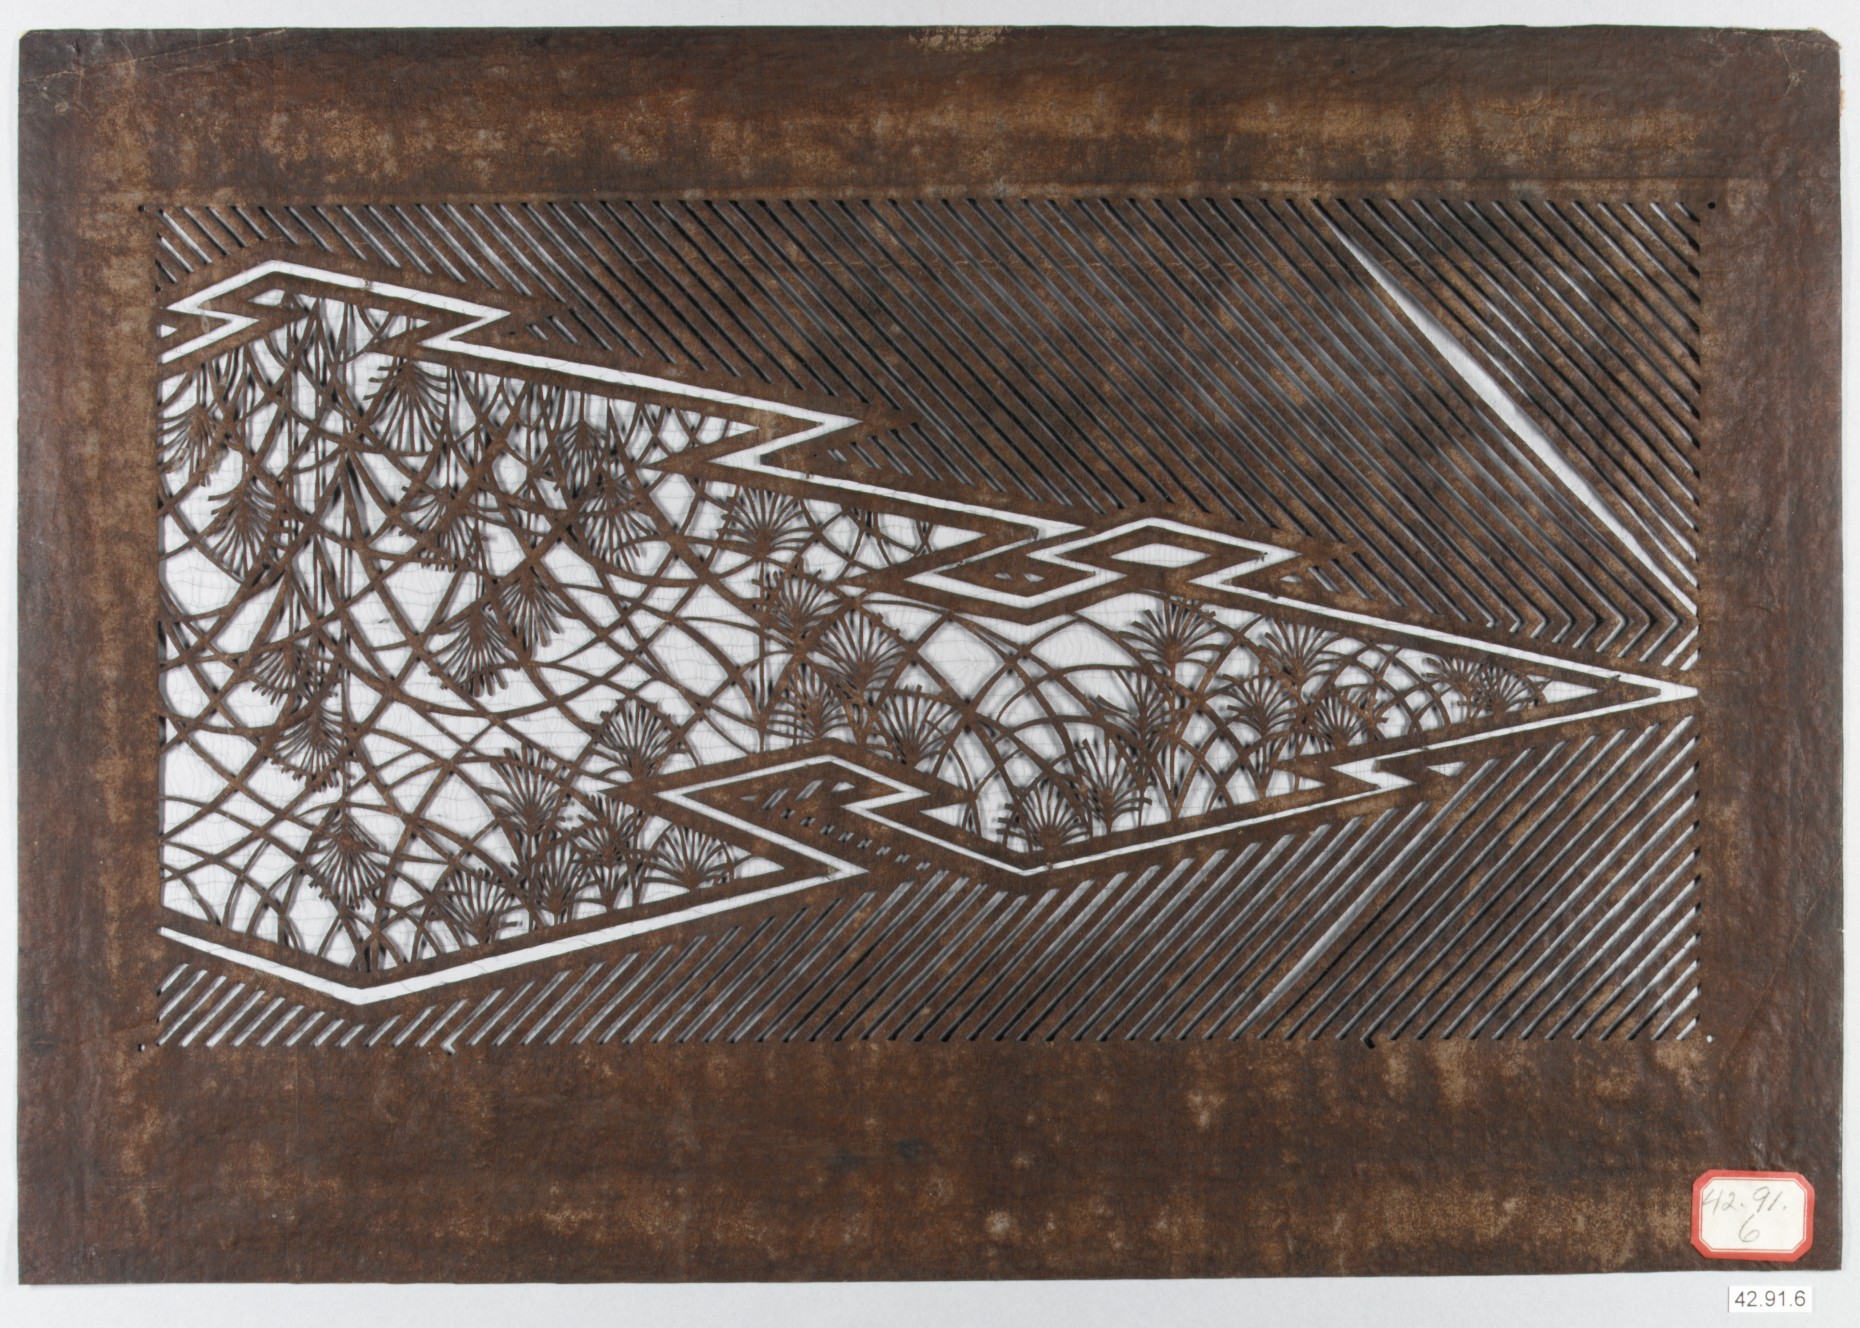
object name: stencil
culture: japanese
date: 1801-1900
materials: paper, silk